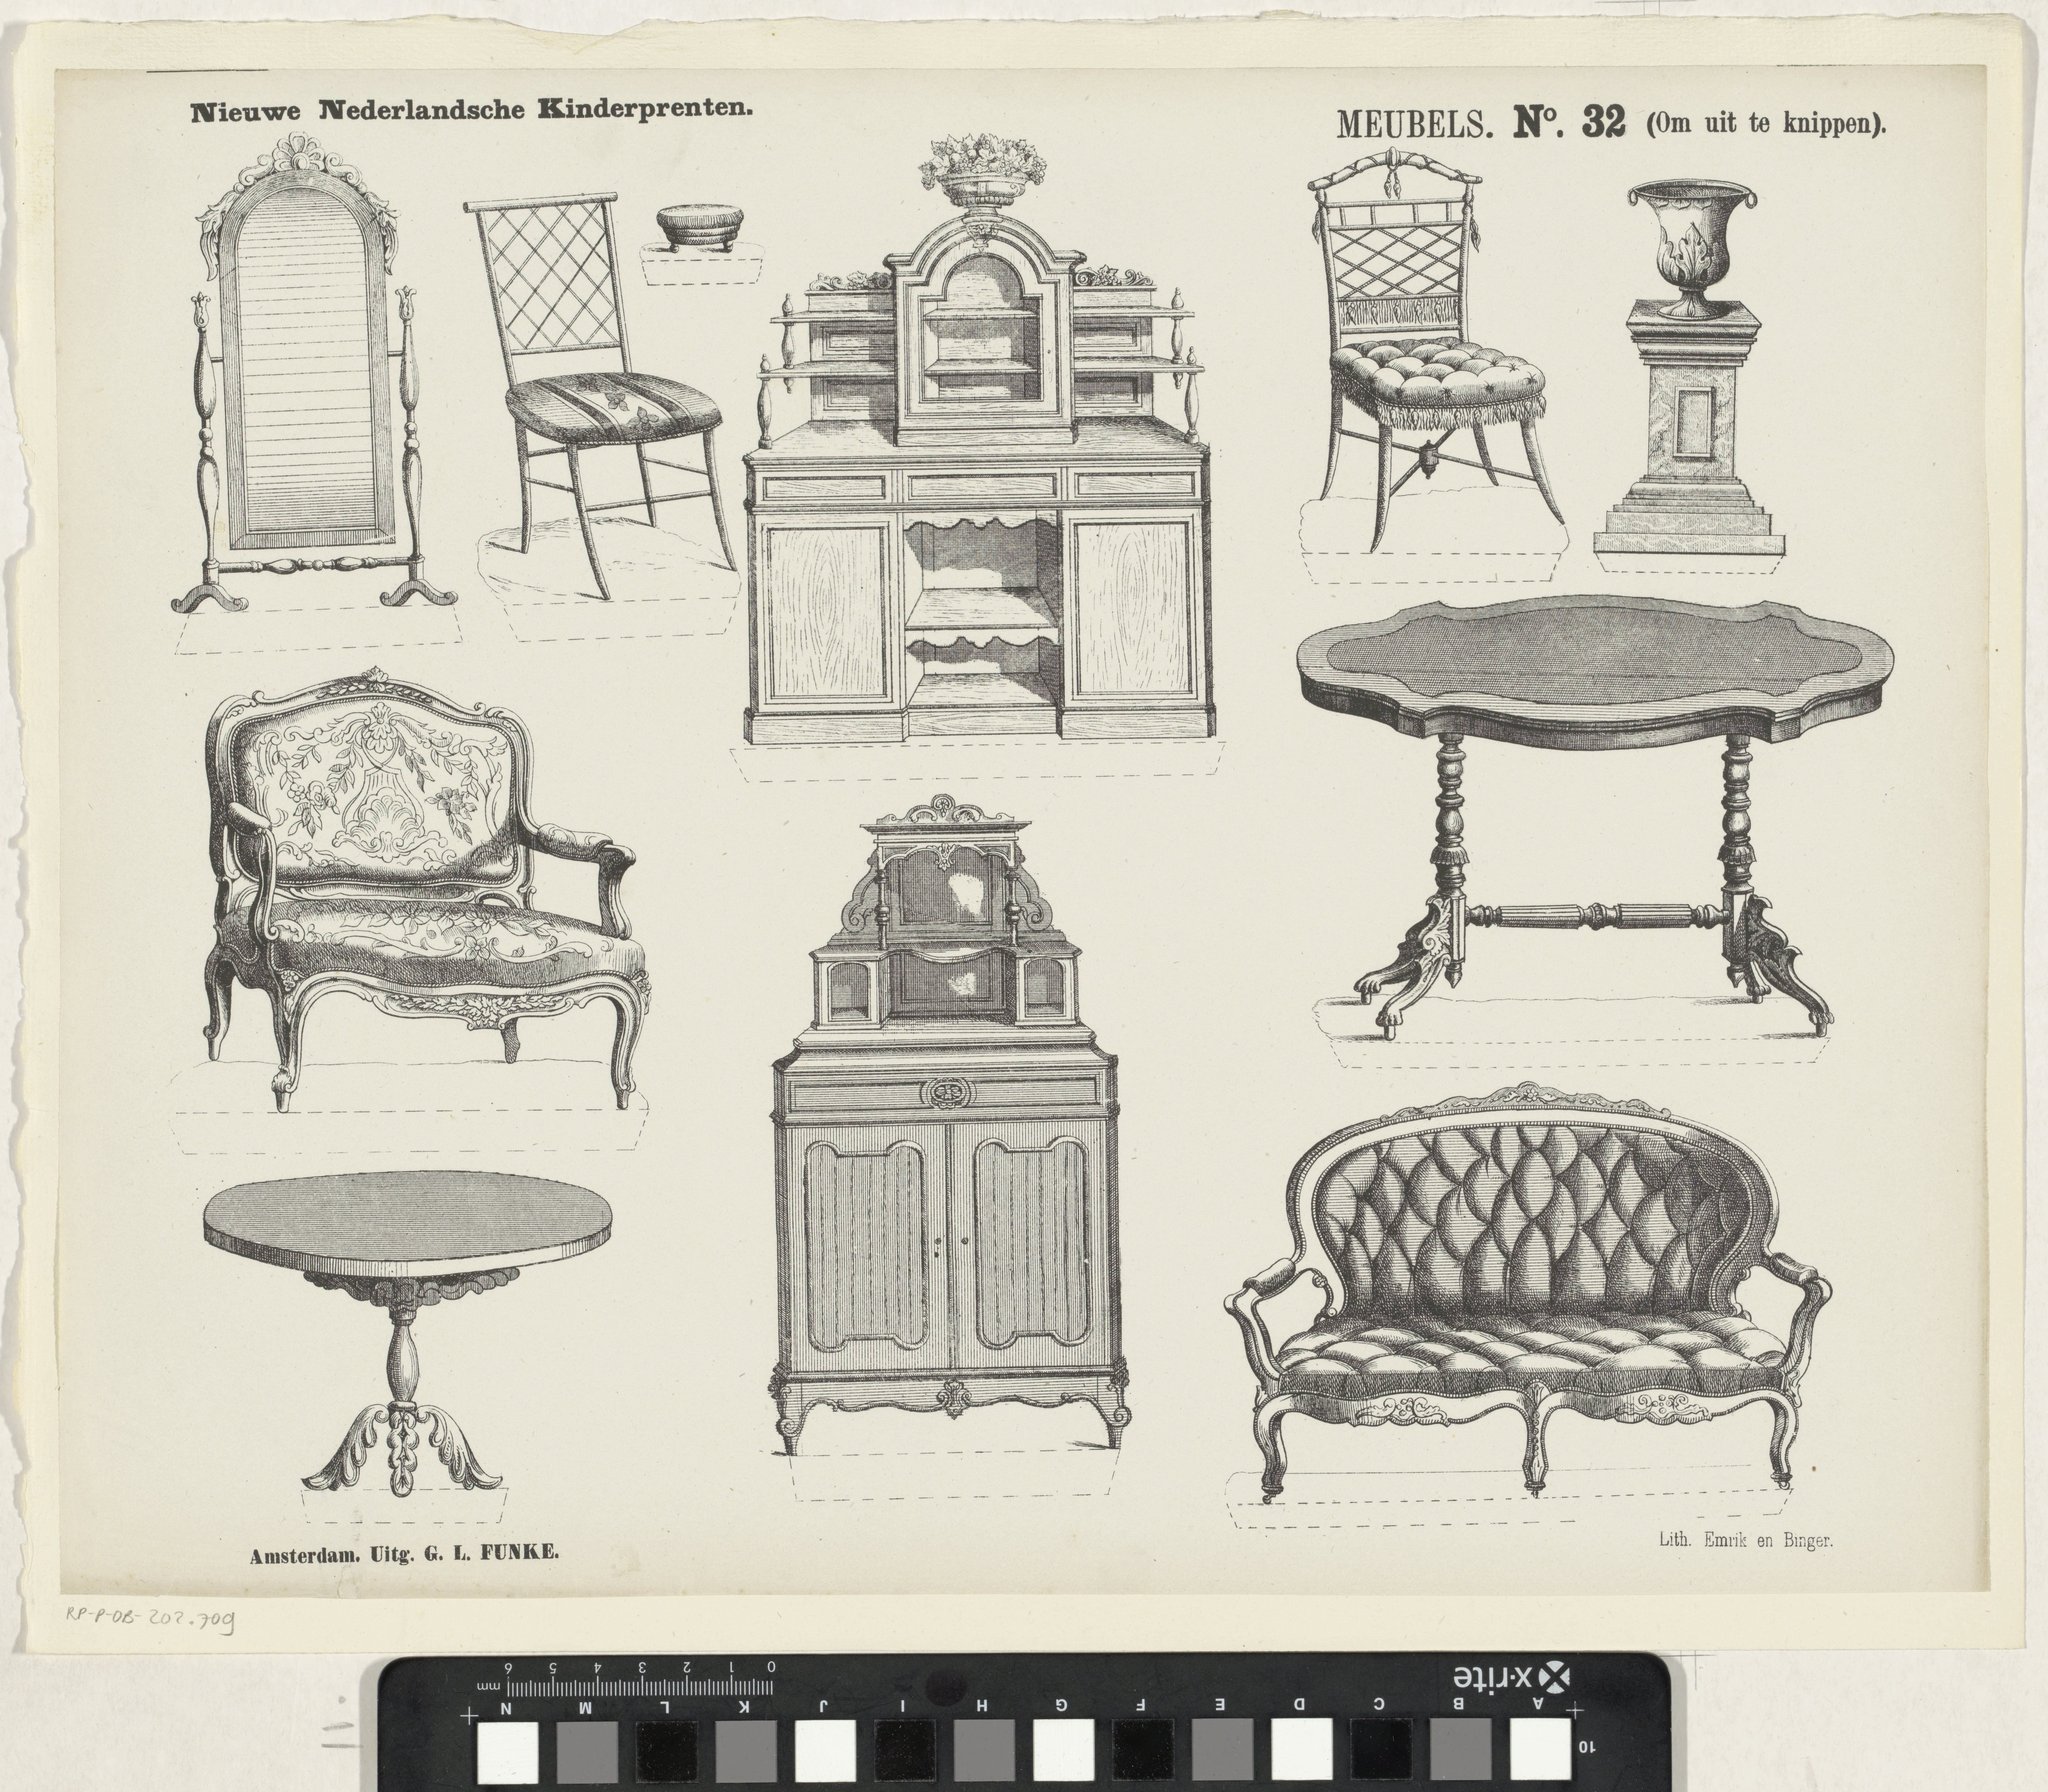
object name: print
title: Meubels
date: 1865-1875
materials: paper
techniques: letterpress printing, lithograph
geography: haarlem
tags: seating furniture, mirror, table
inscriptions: collector's mark: Lugt 2760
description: Blad met 11 voorstellingen van meubelstukken om uit te knippen, waaronder stoelen, kasten en tafels. Genummerd rechtsboven: No. 32.